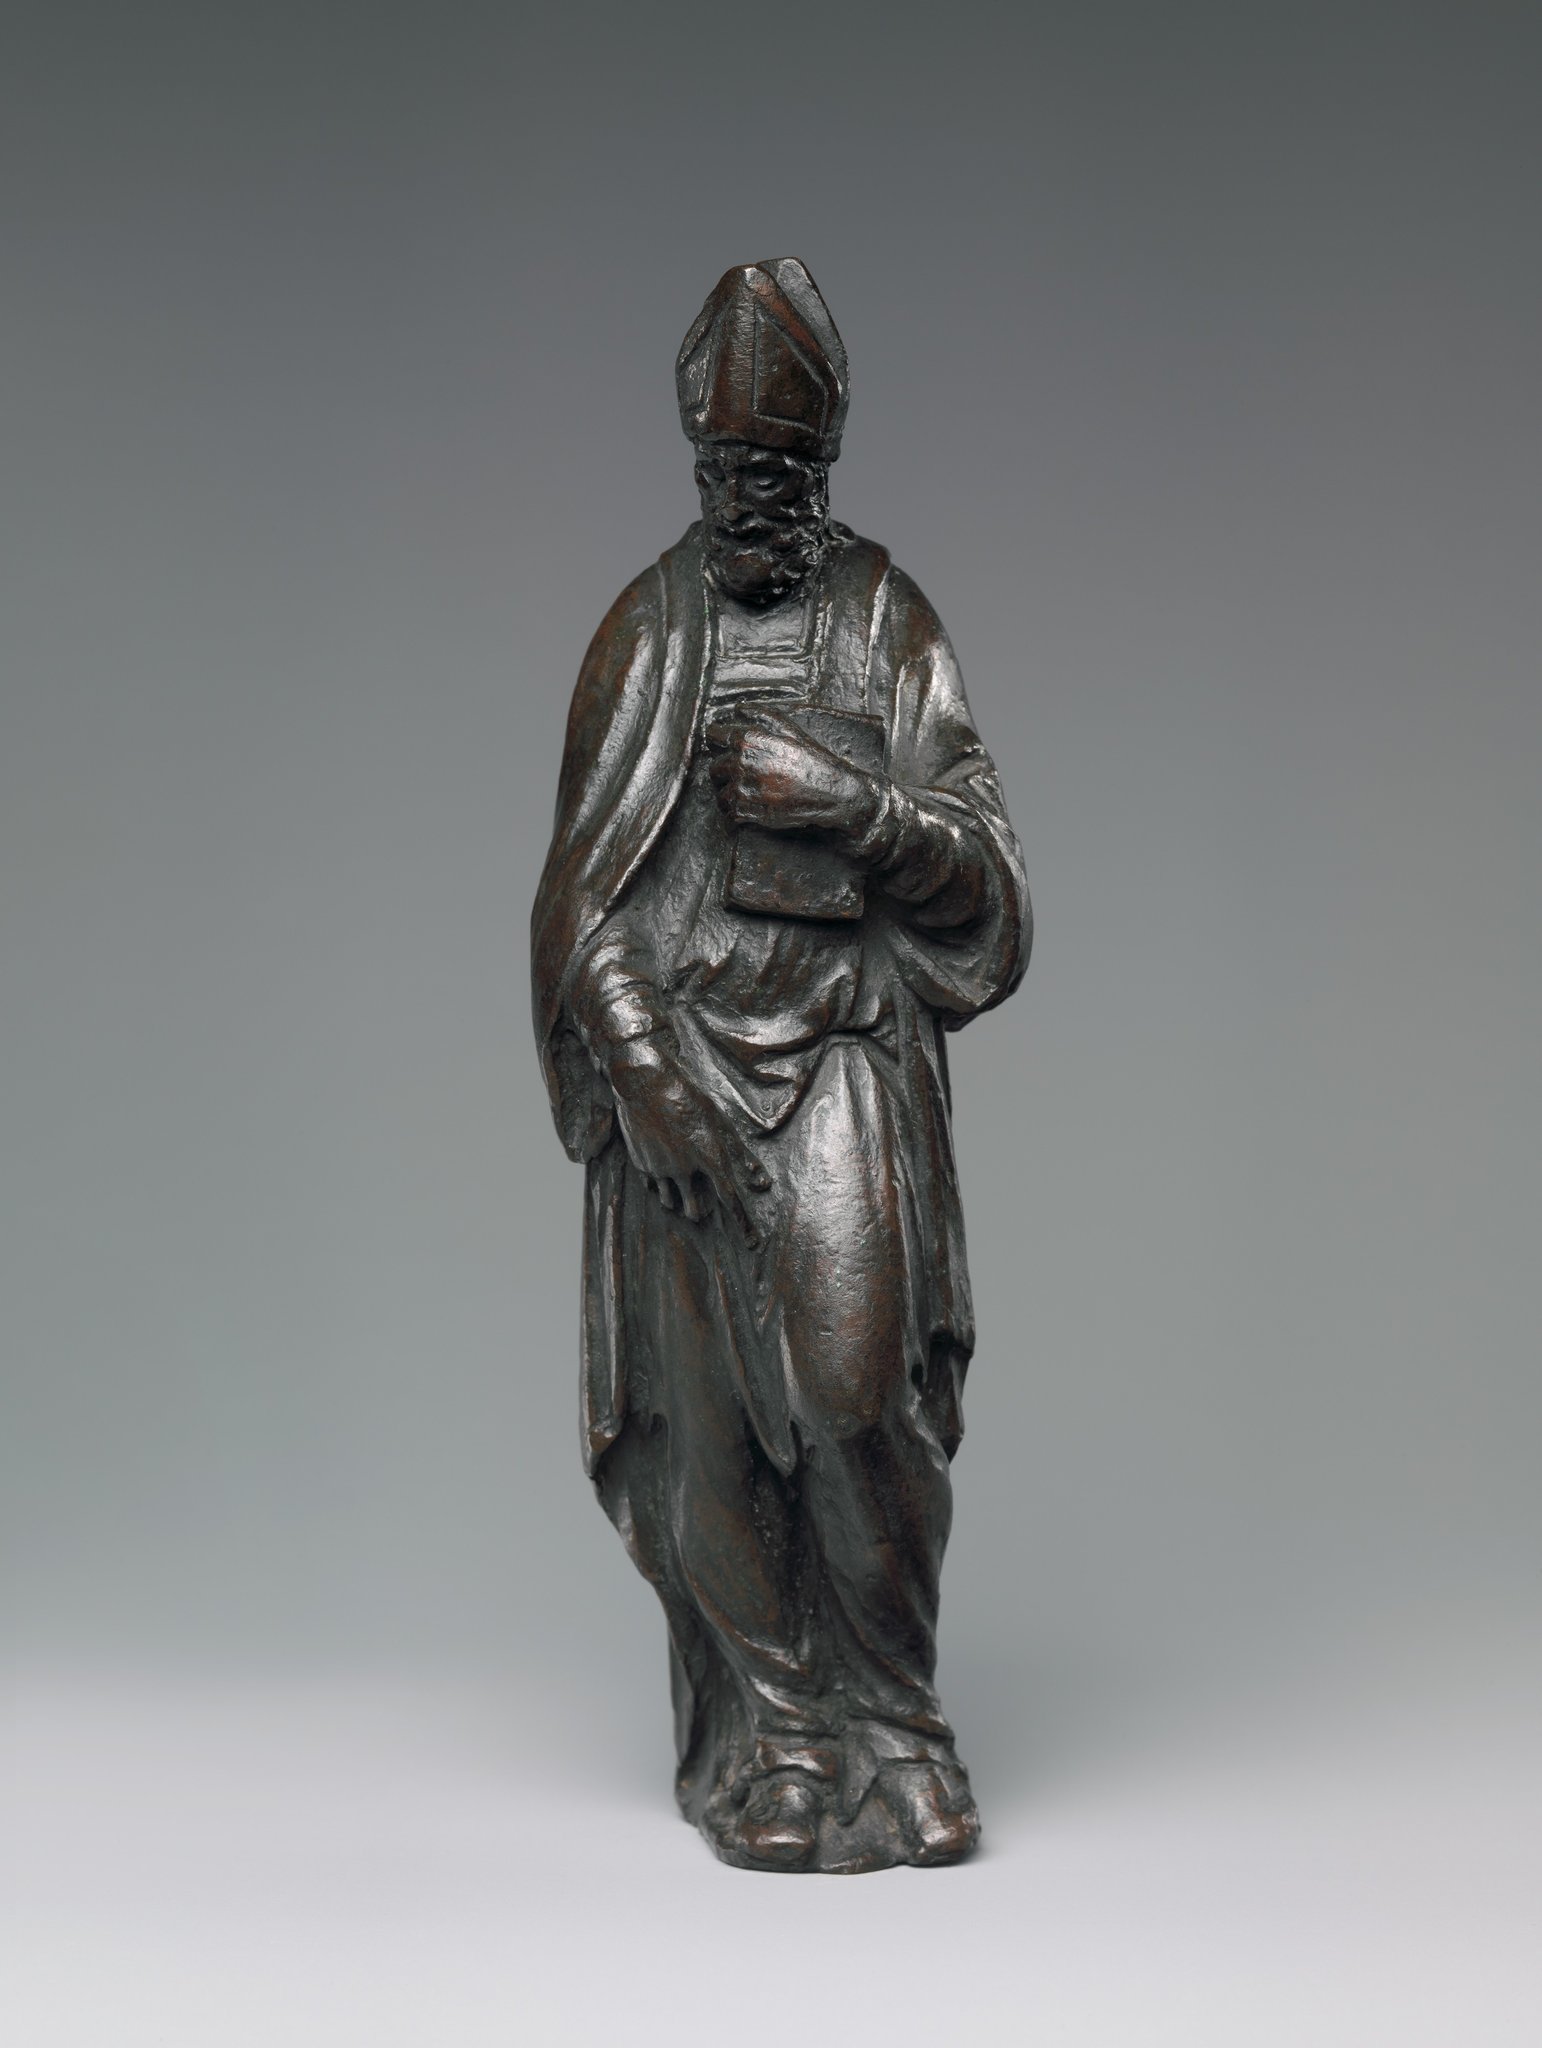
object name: statuette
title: Bishop (Saint Augustine?)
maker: jacopo sansovino (jacopo tatti)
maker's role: artist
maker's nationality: italian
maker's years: 1486-1570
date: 1550-1600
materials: bronze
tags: saints